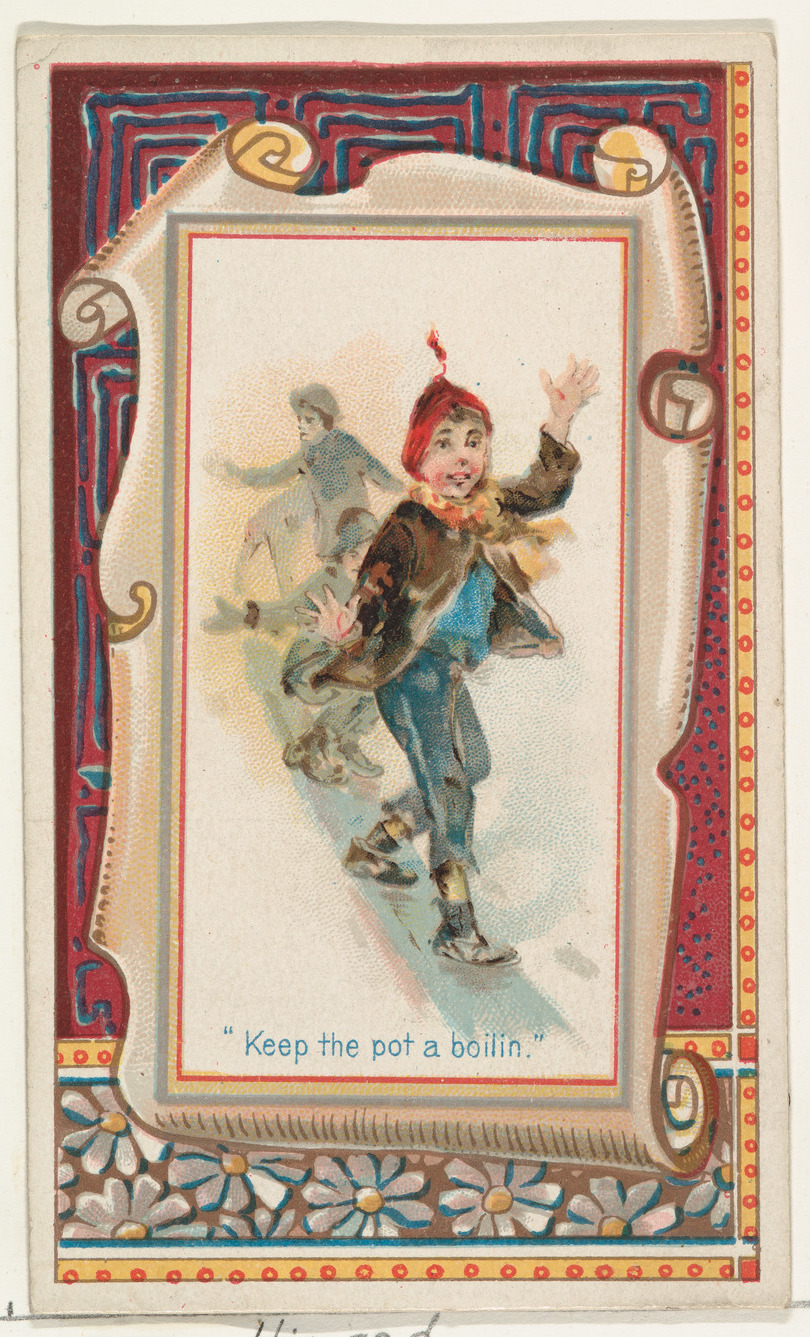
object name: print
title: "Keep the pot a boilin" from the Terrors of America set (N136) issued by Duke Sons & Co. to promote Honest Long Cut Tobacco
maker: w. duke, sons & co.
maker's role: publisher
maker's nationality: american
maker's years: 1870-1920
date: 1888-1889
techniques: color lithograph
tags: boys